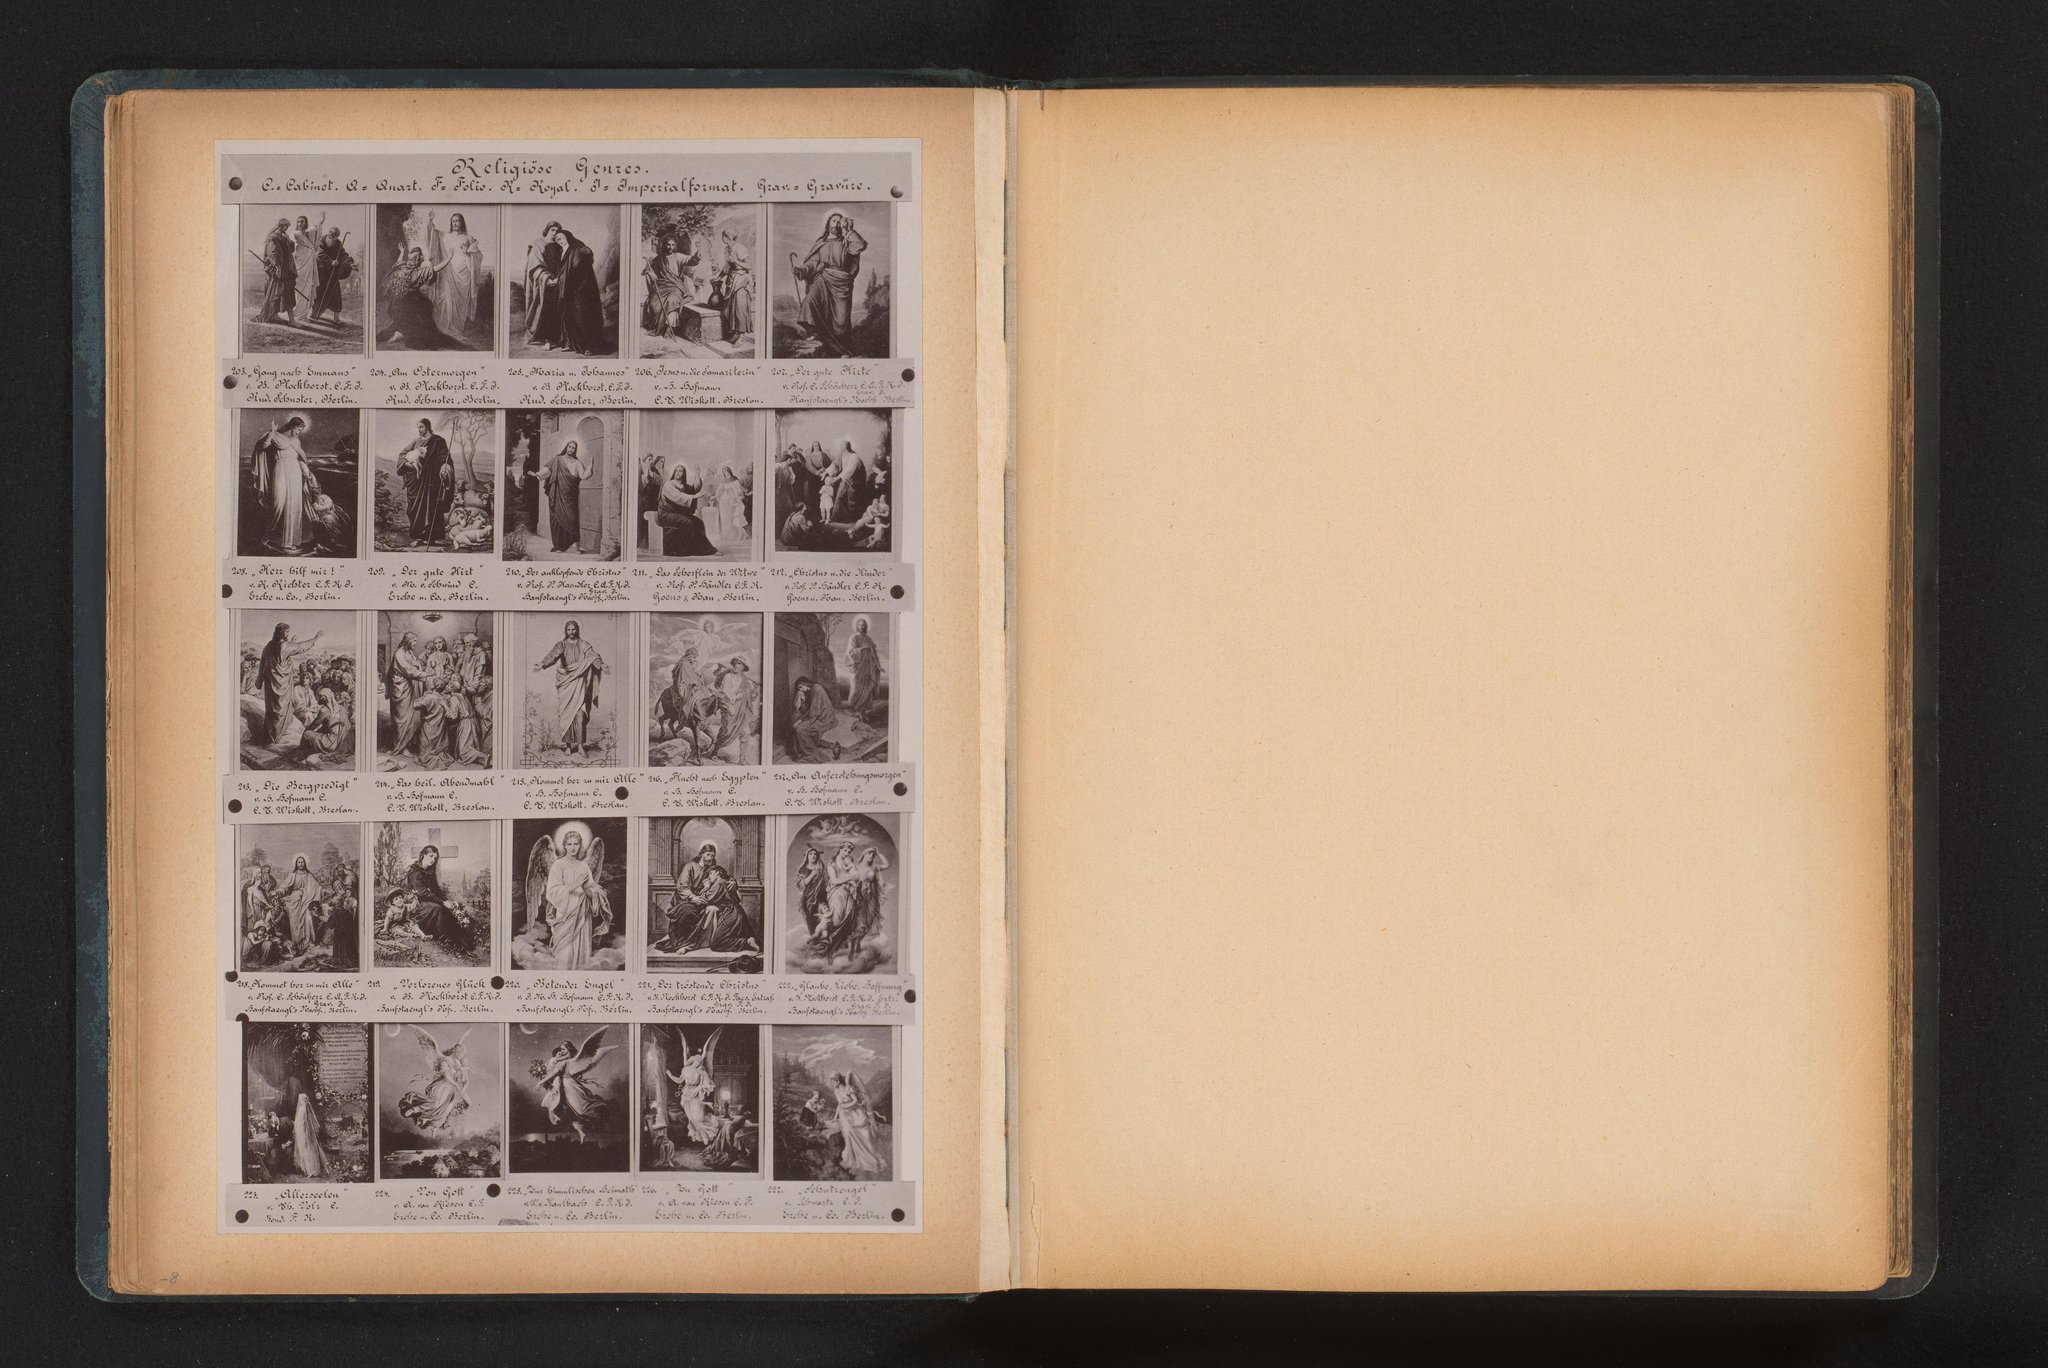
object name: reproduction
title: Religiöse Genres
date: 1880-1885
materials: paper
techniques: photograph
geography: berlin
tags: saints